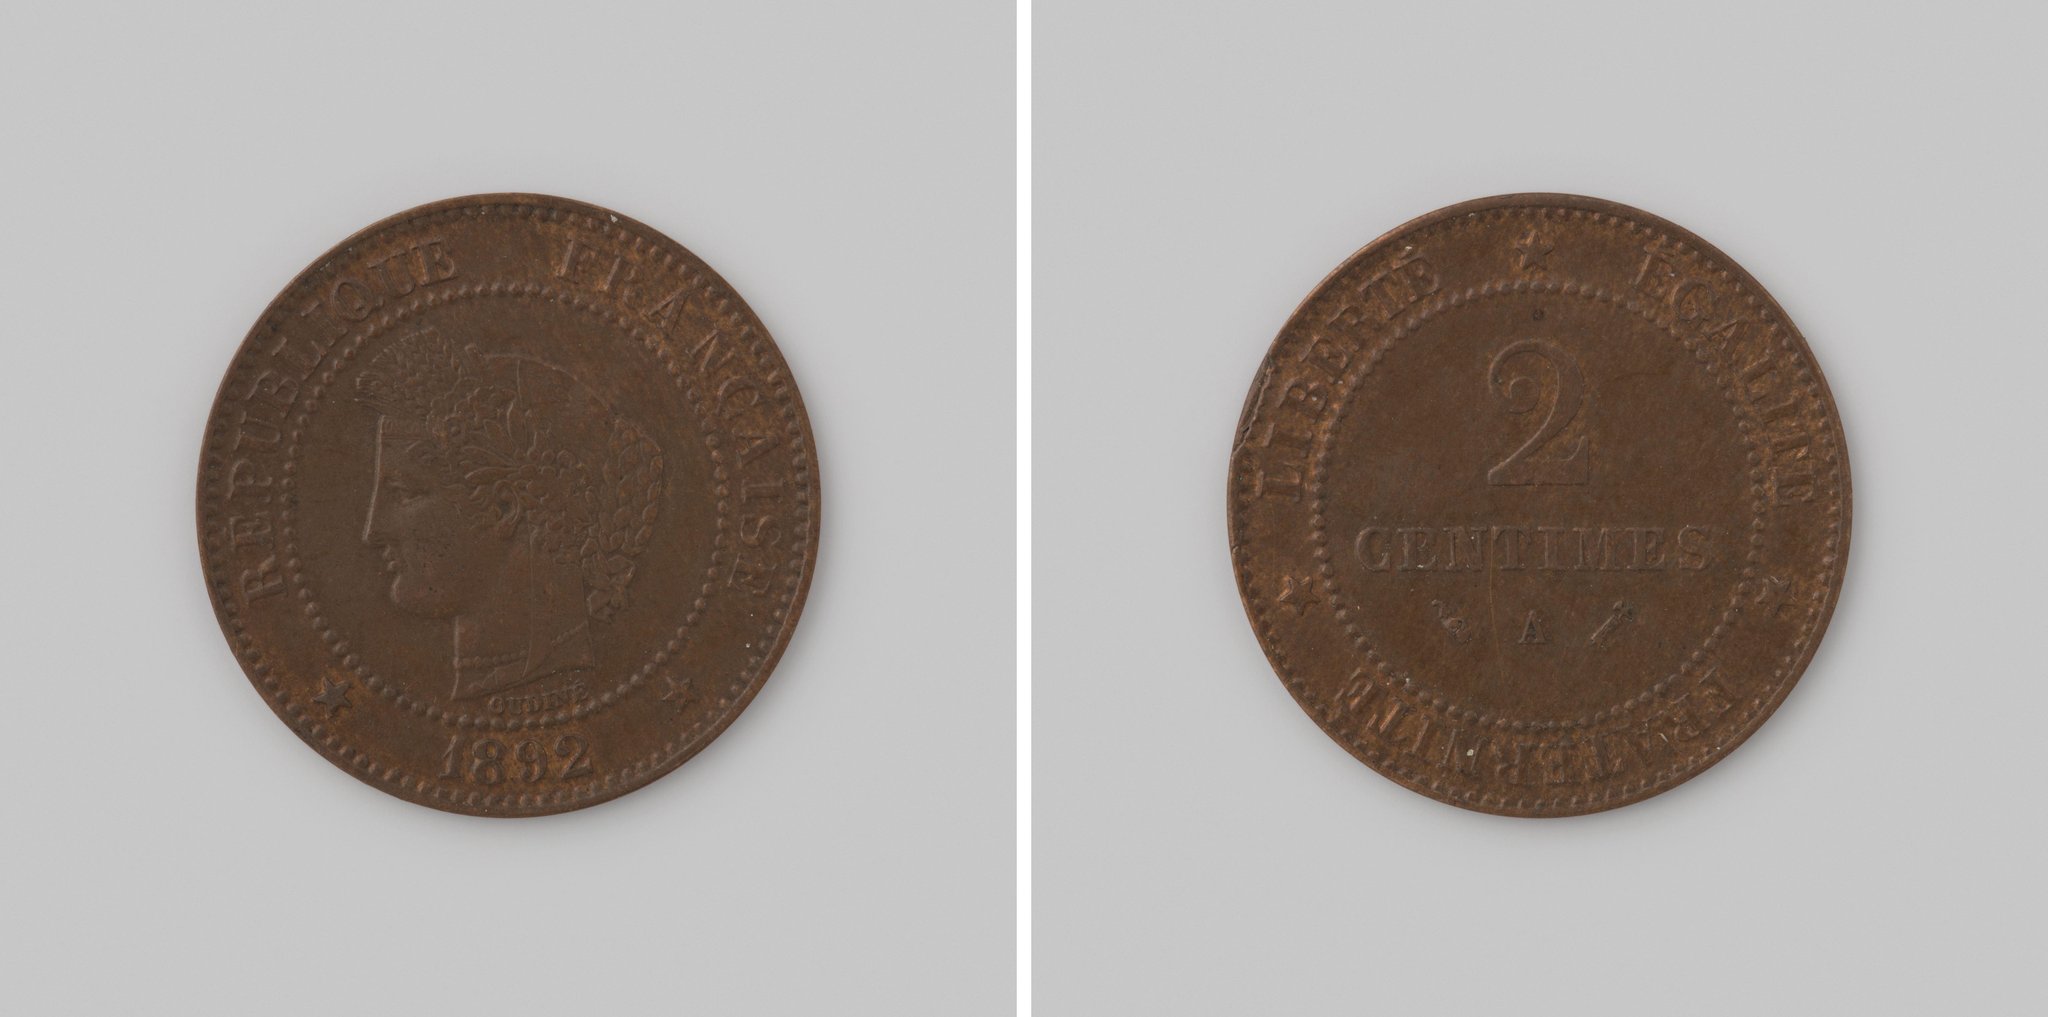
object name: twee centime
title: Frankrijk, Derde Republiek, 2 centimes, 1892 A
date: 1892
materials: bronze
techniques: striking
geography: paris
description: Bronzen munt. Voorzijde: portret van een vrouw met krans en diadeem naar links.Jaartal onderaan. Keerzijde: binnen twee samengebonden takken waarde-aanduiding in twee regels, waaronder de letter A [=Parijs]. Gladde rand.